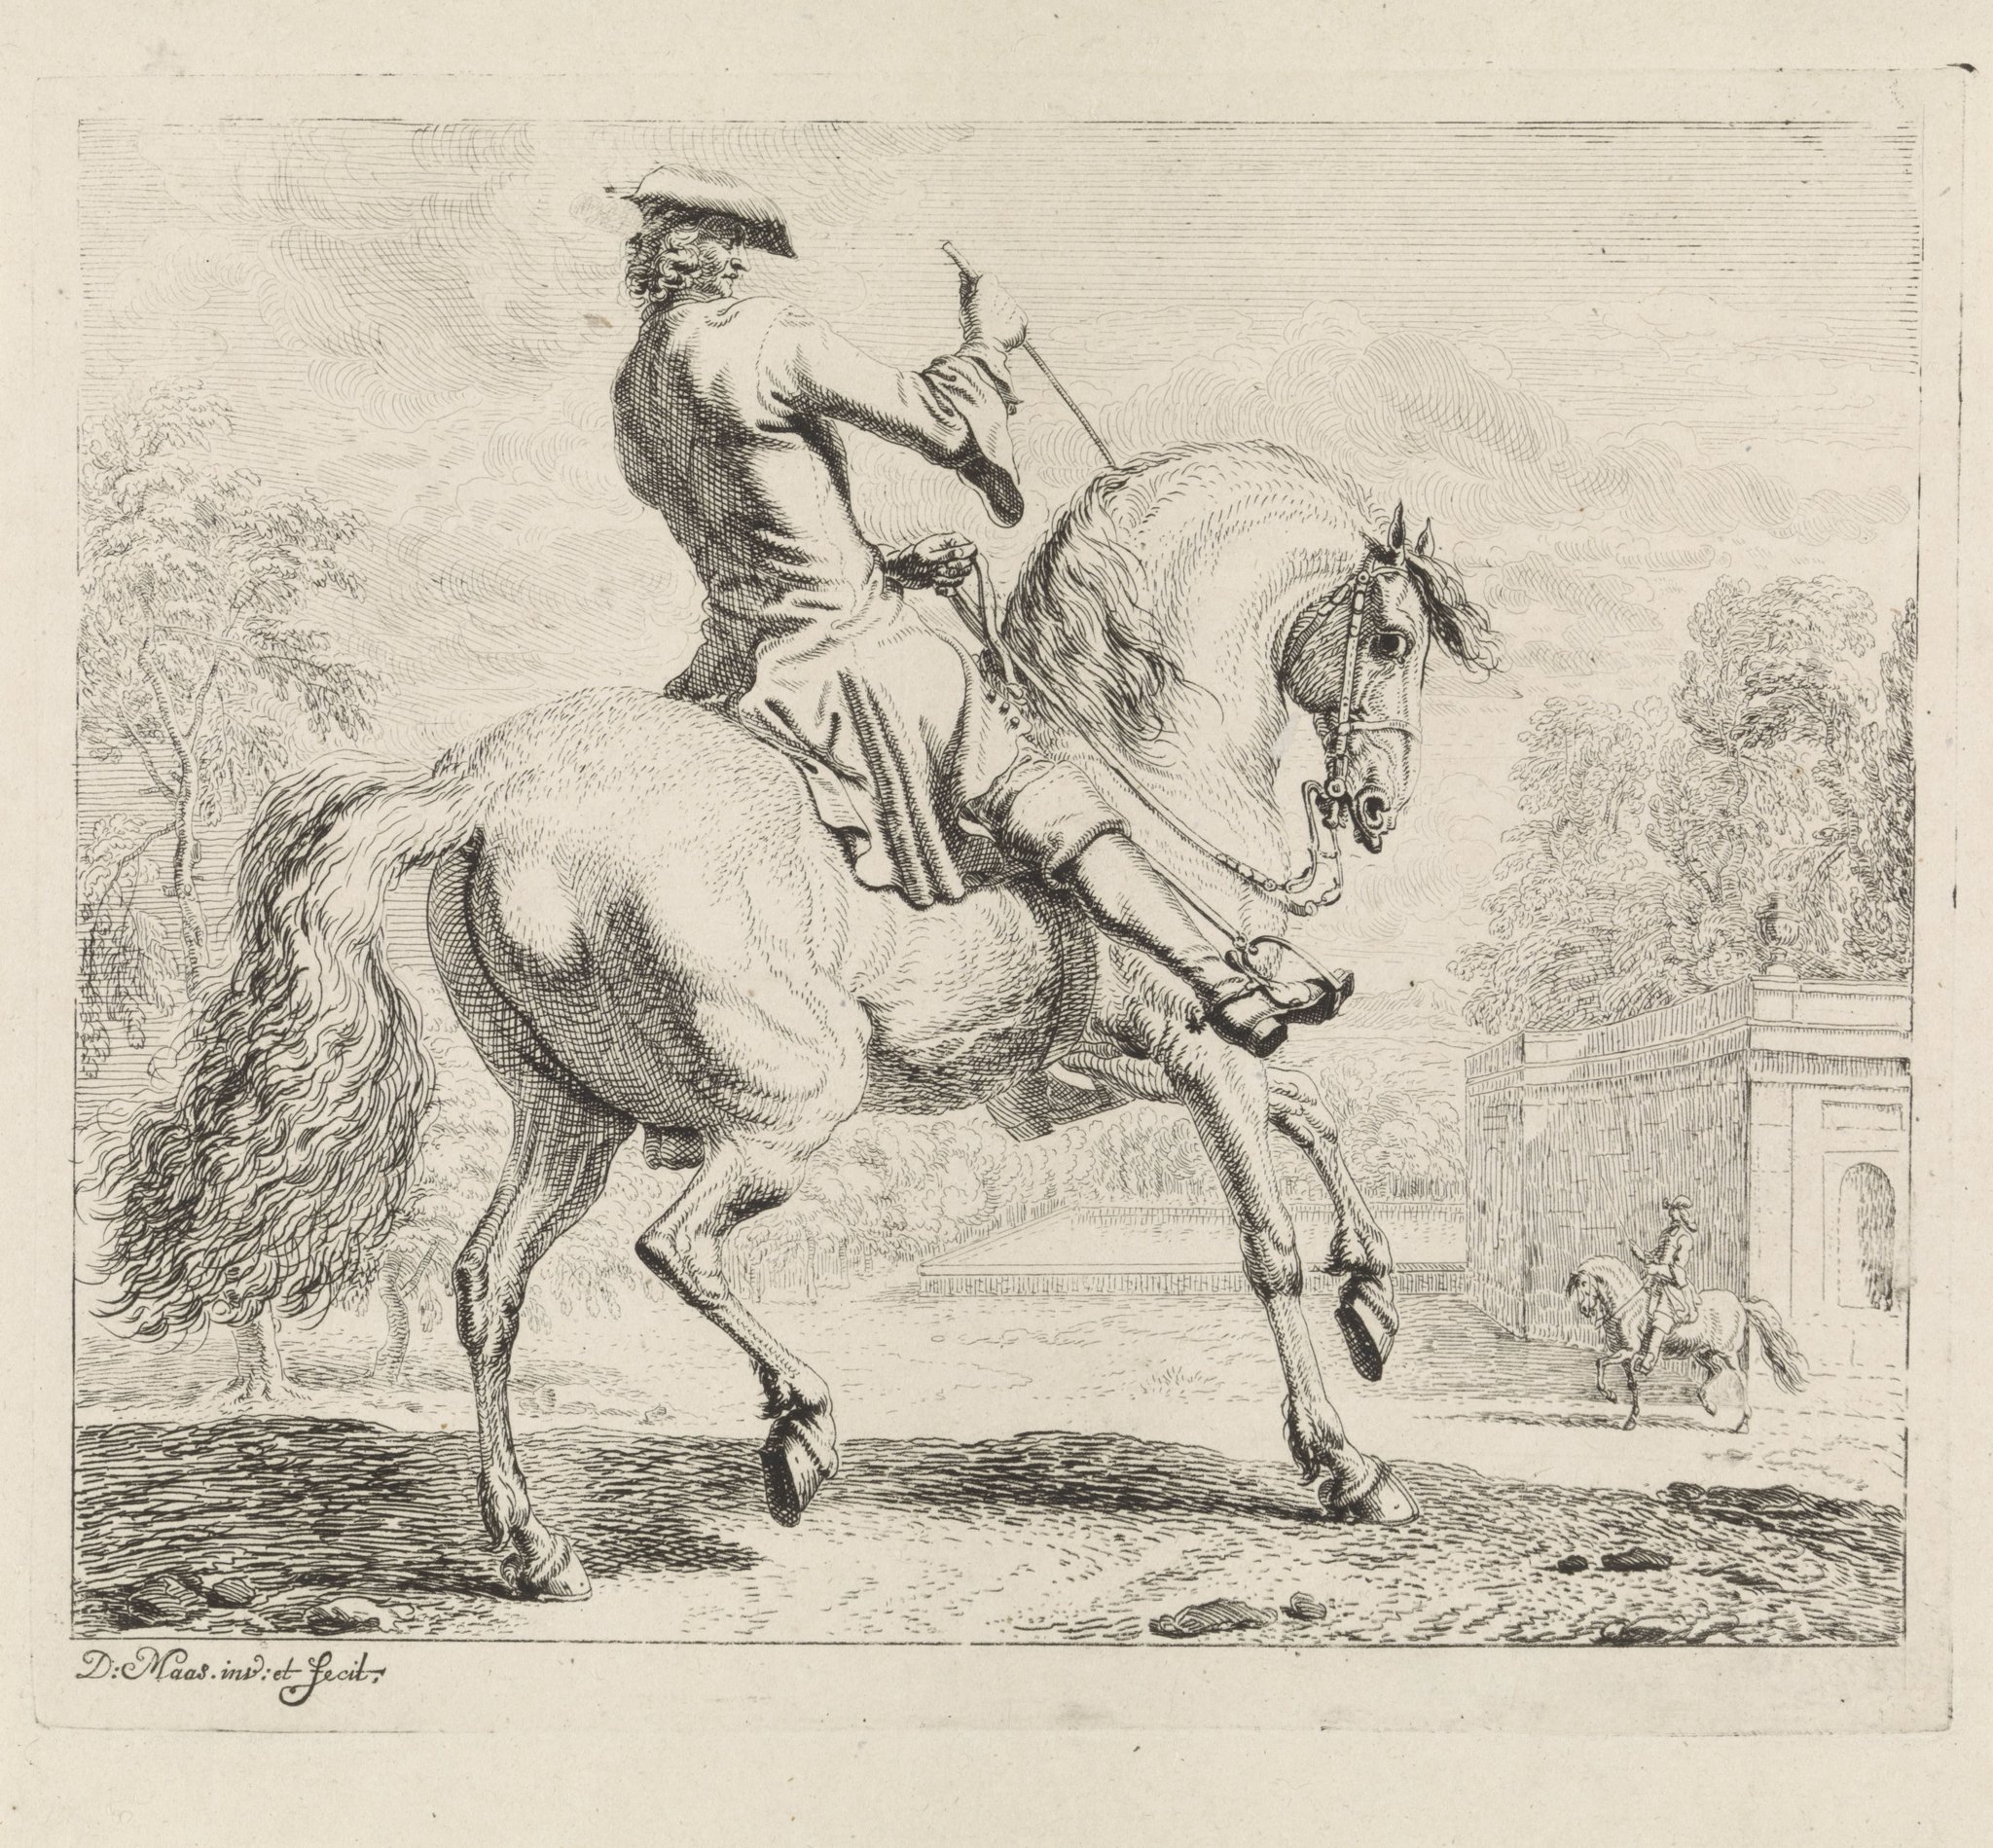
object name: print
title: Twee ruiters bij een muur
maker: dirk maas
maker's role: draughtsman, print maker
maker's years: 1659-1717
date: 1669-1717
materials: paper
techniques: etching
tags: riding a horse, ass, or mule; rider, horseman, training of horses, riding-school, manège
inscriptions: collector's mark: Lugt 240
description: Ruiter naar rechts in een landschap, rechts op de achtergrond een tweede ruiter bij een muur. Prent uit een serie van negen prenten met onderwerp de manege.